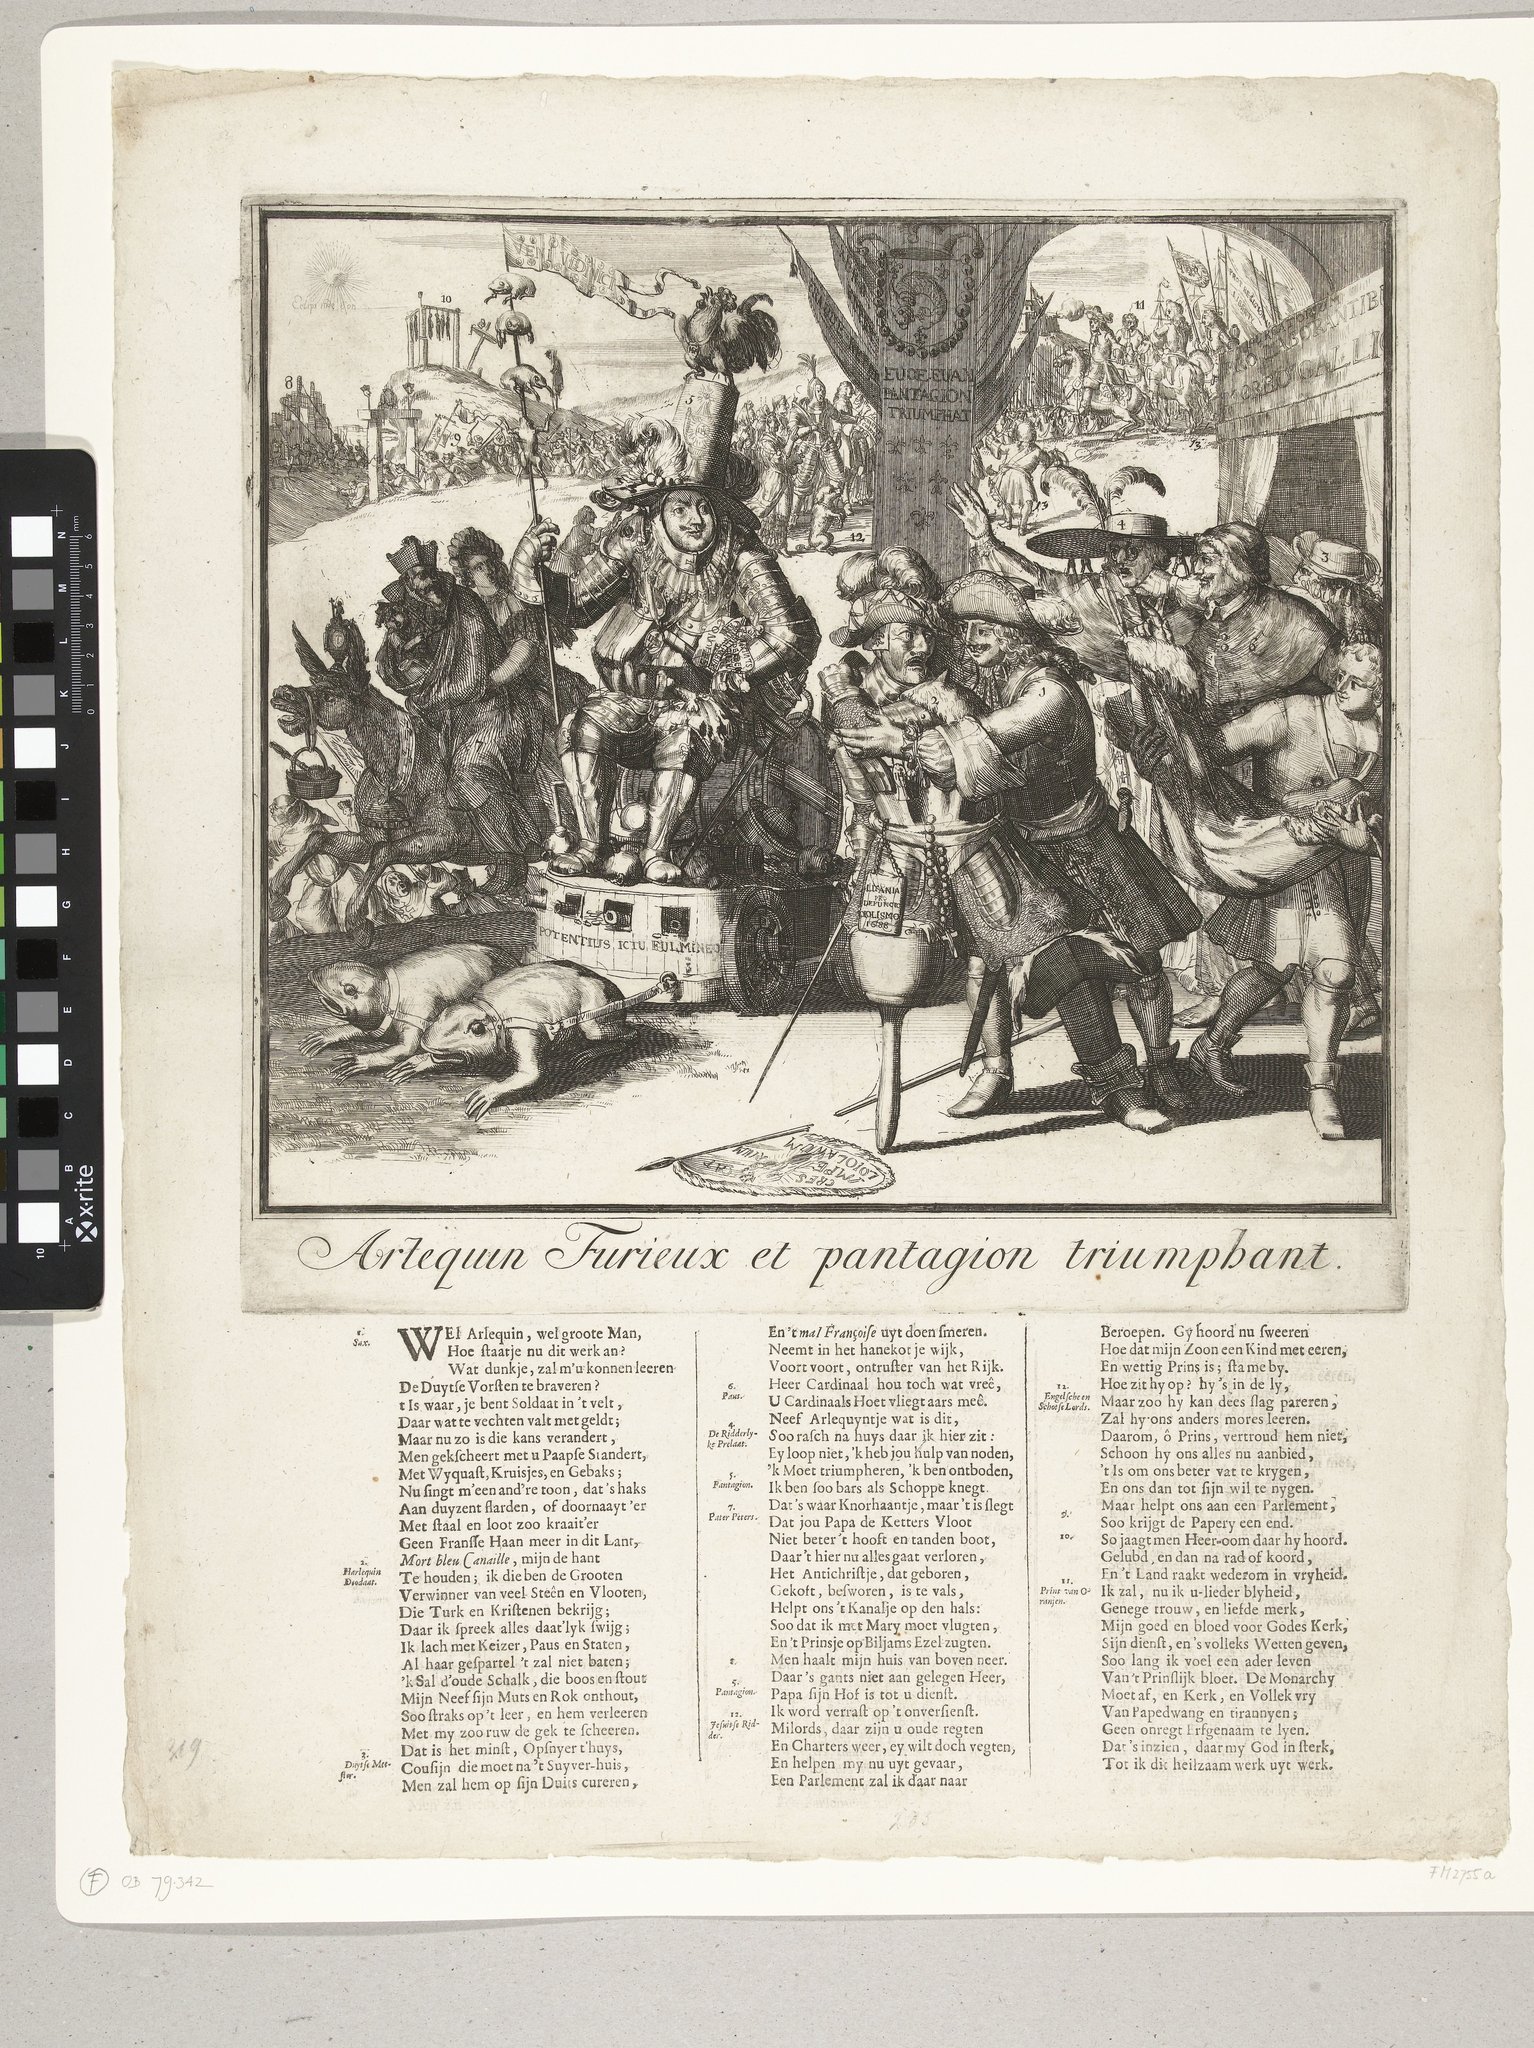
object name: cartoon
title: Spotprent op Lodewijk XIV en de dauphin, 1689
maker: romeyn de hooghe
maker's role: draughtsman, goldsmith, painter, print maker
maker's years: 1645-1708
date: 1689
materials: paper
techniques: engraving, etching, letterpress printing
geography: northern netherlands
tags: jacobus ii (koning van engeland en schotland), lodewijk xiv (koning van frankrijk), paris, clergyman, alexander viii, dauphin van frankrijk lodewijk, london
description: Spotprent op Lodewijk XIV (Harlekijn) en Lodewijk, dauphin van Frankrijk, 1689. De dauphin op een triomfwagen getrokken door padden, zijn vader Lodewijk XIV wordt door een Duitse soldaat tegengehouden ten strijde te trekken. Rechts de paus en de kardinaal von Fürstenberg. Links vluchten de jezuïet pater Peters (Edward Petre) met Mary van Modena en het ondergeschoven kind Jacobus Frans Eduard op een ezel. Op de achtergrond Jacobus II en Willem III. Onder de voorstelling een vers in 3 kolommen met een toelichting op de nummers 1-12 in het Nederlands.